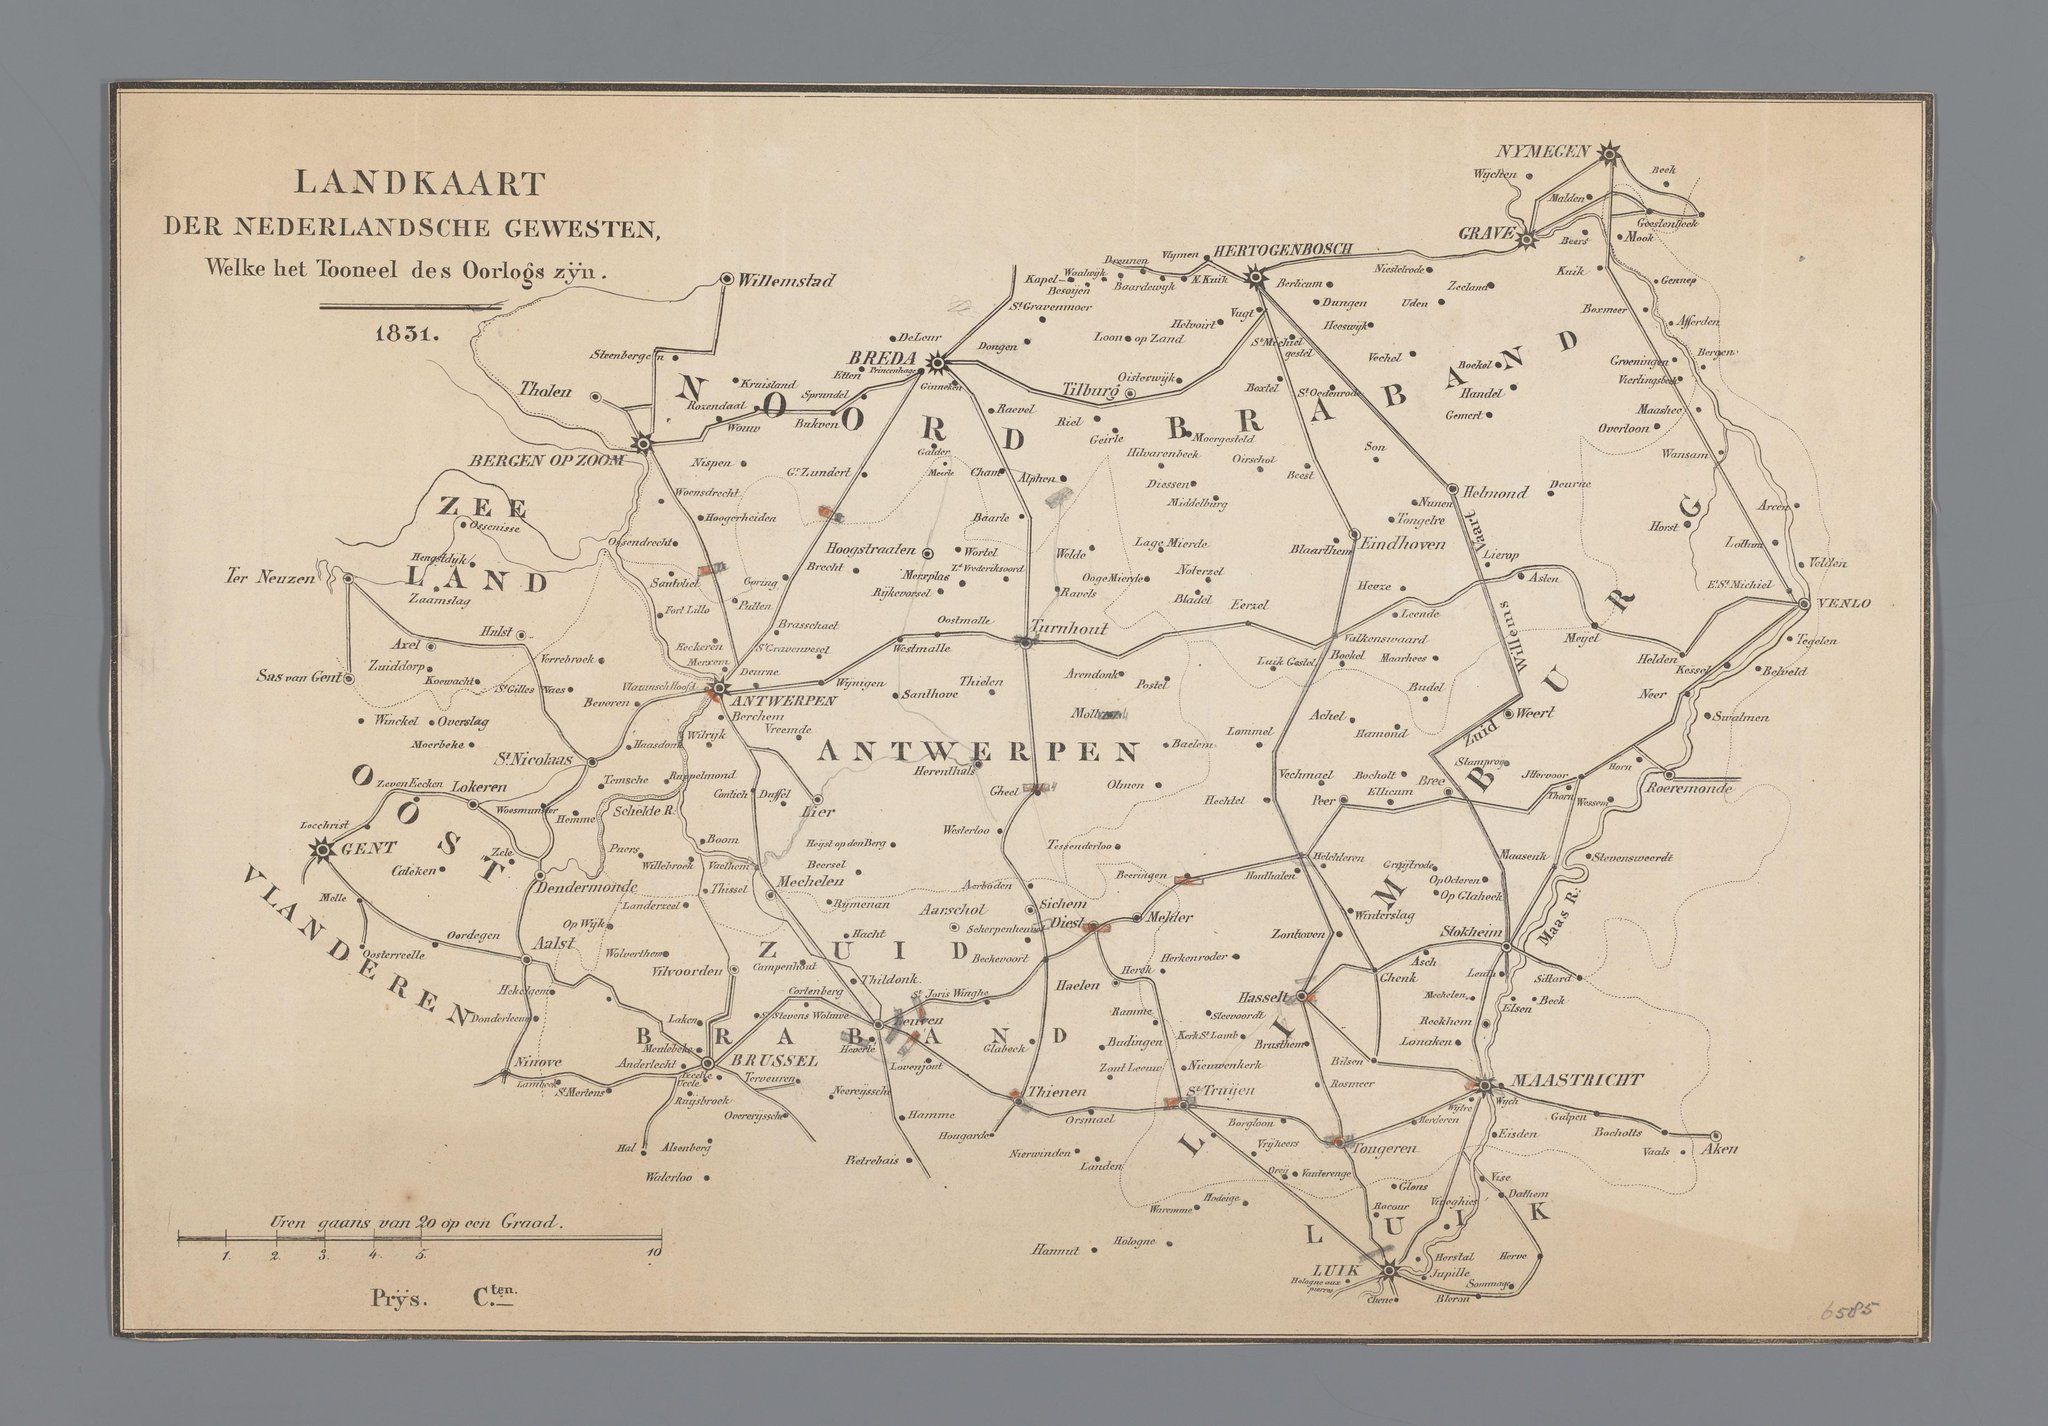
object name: print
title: Kaart van het oorlogsterrein, 1831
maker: Anonymous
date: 1831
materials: paper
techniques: lithograph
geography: netherlands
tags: maps of separate countries or regions, netherlands, belgium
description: Kaart van het oorlogsterrein in Noord-Brabant en de noordelijke Belgische provincies, 1831.